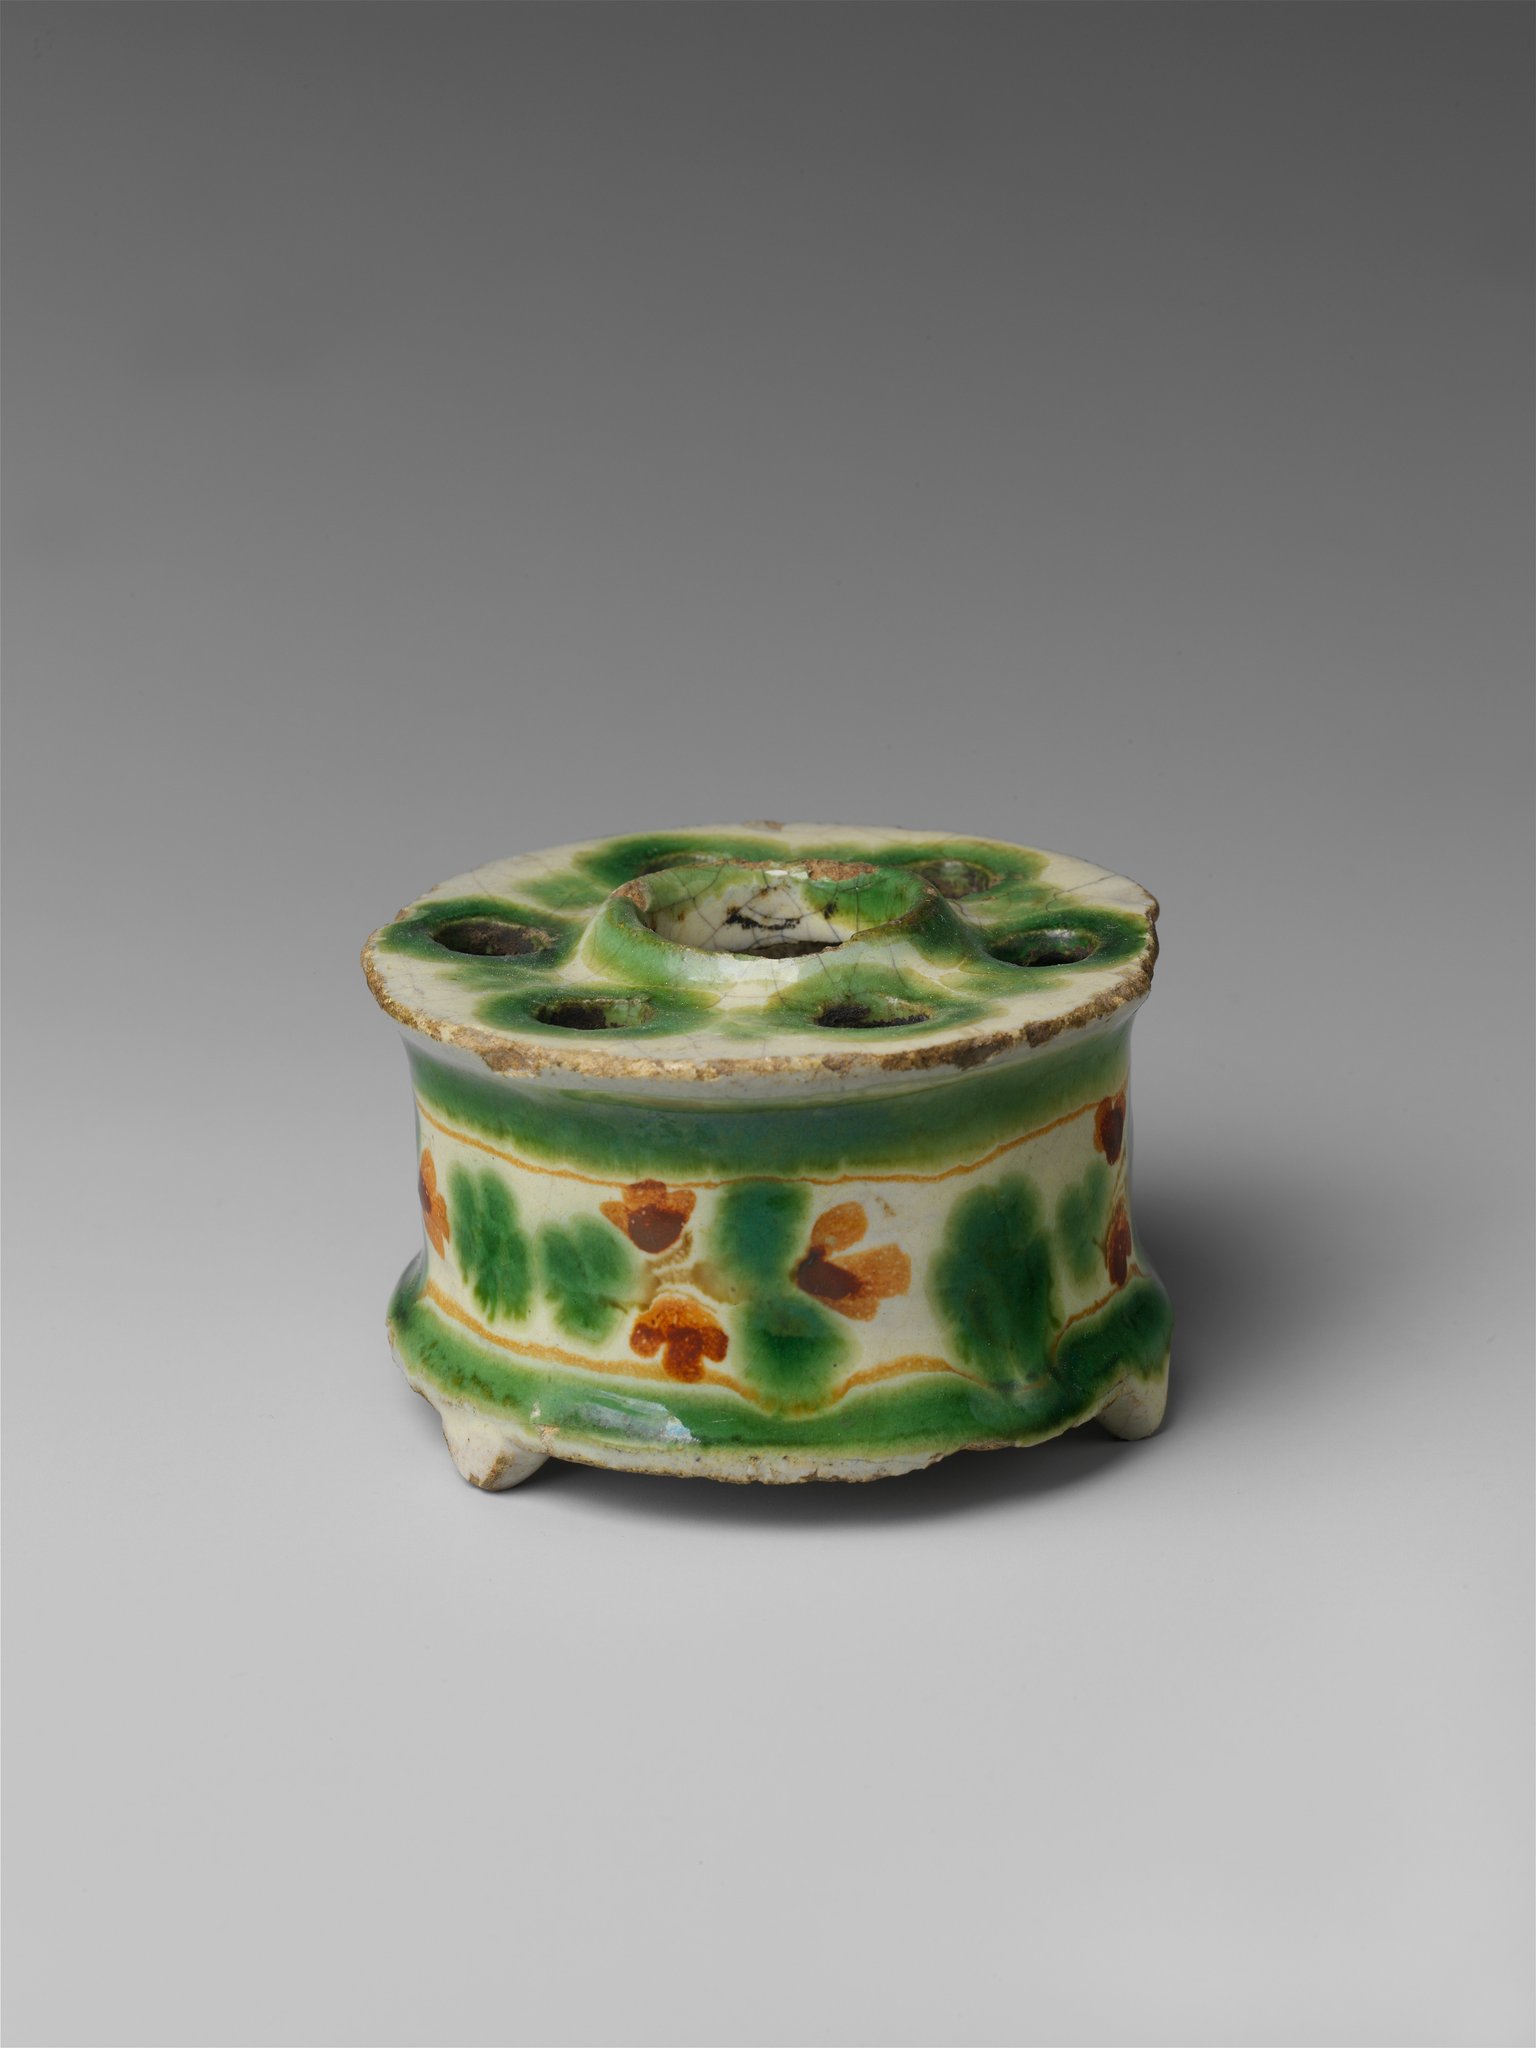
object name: inkwell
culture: mexican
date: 1840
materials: earthenware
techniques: glazing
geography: mexico